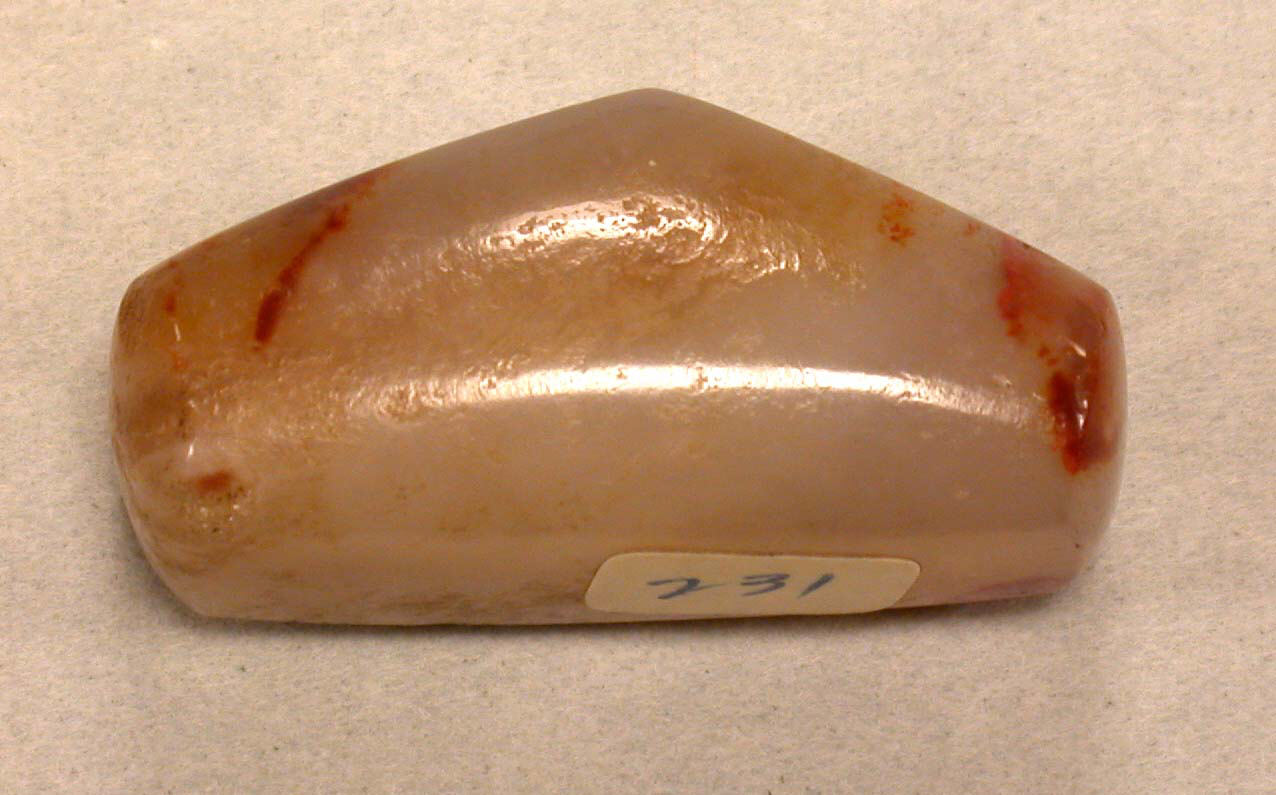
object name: ritual stone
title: Stone Pulidor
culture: mexican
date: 1501-1600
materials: stone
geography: mexico